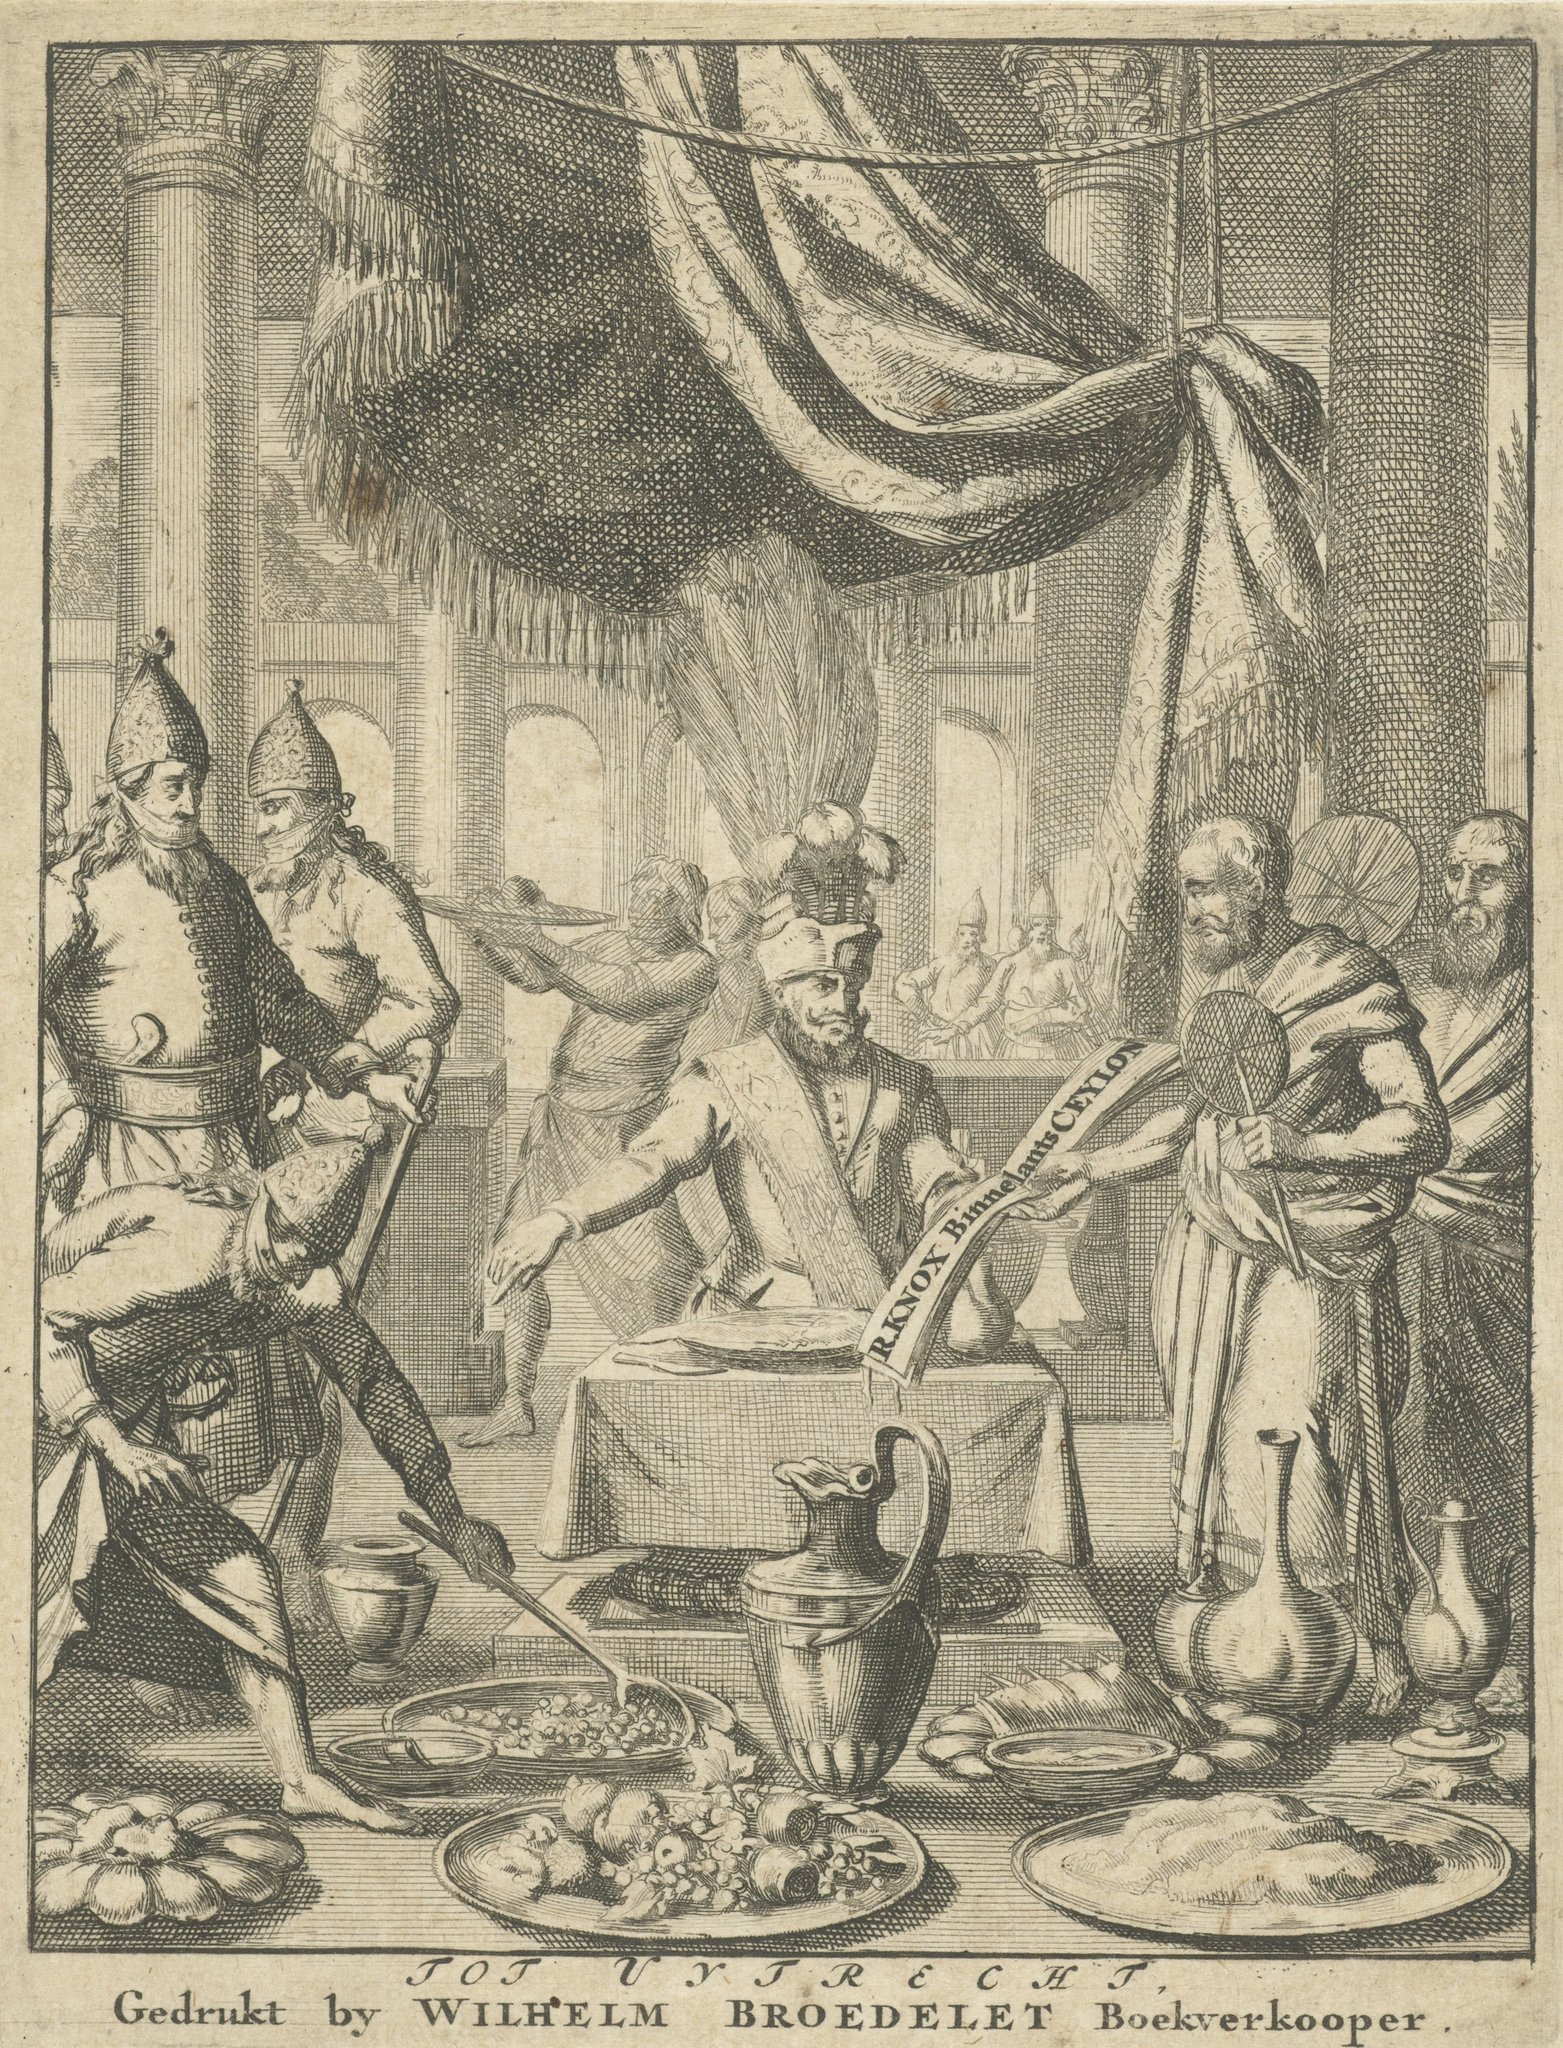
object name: print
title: Twee priesters bieden een koning tijdens de maaltijd een geopend boek aan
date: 1692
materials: paper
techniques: etching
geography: utrecht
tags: book - mm - book open, celebration meal, feast, banquet, king, priests ~ hierarchy of priests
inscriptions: collector's mark: Lugt 2228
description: Titelpagina voor: Knox, Robert. t'Eyland Ceylon in sĳn binnenste, of't koningrijck Candy. Utrecht: Willem Broedelet, 1692.